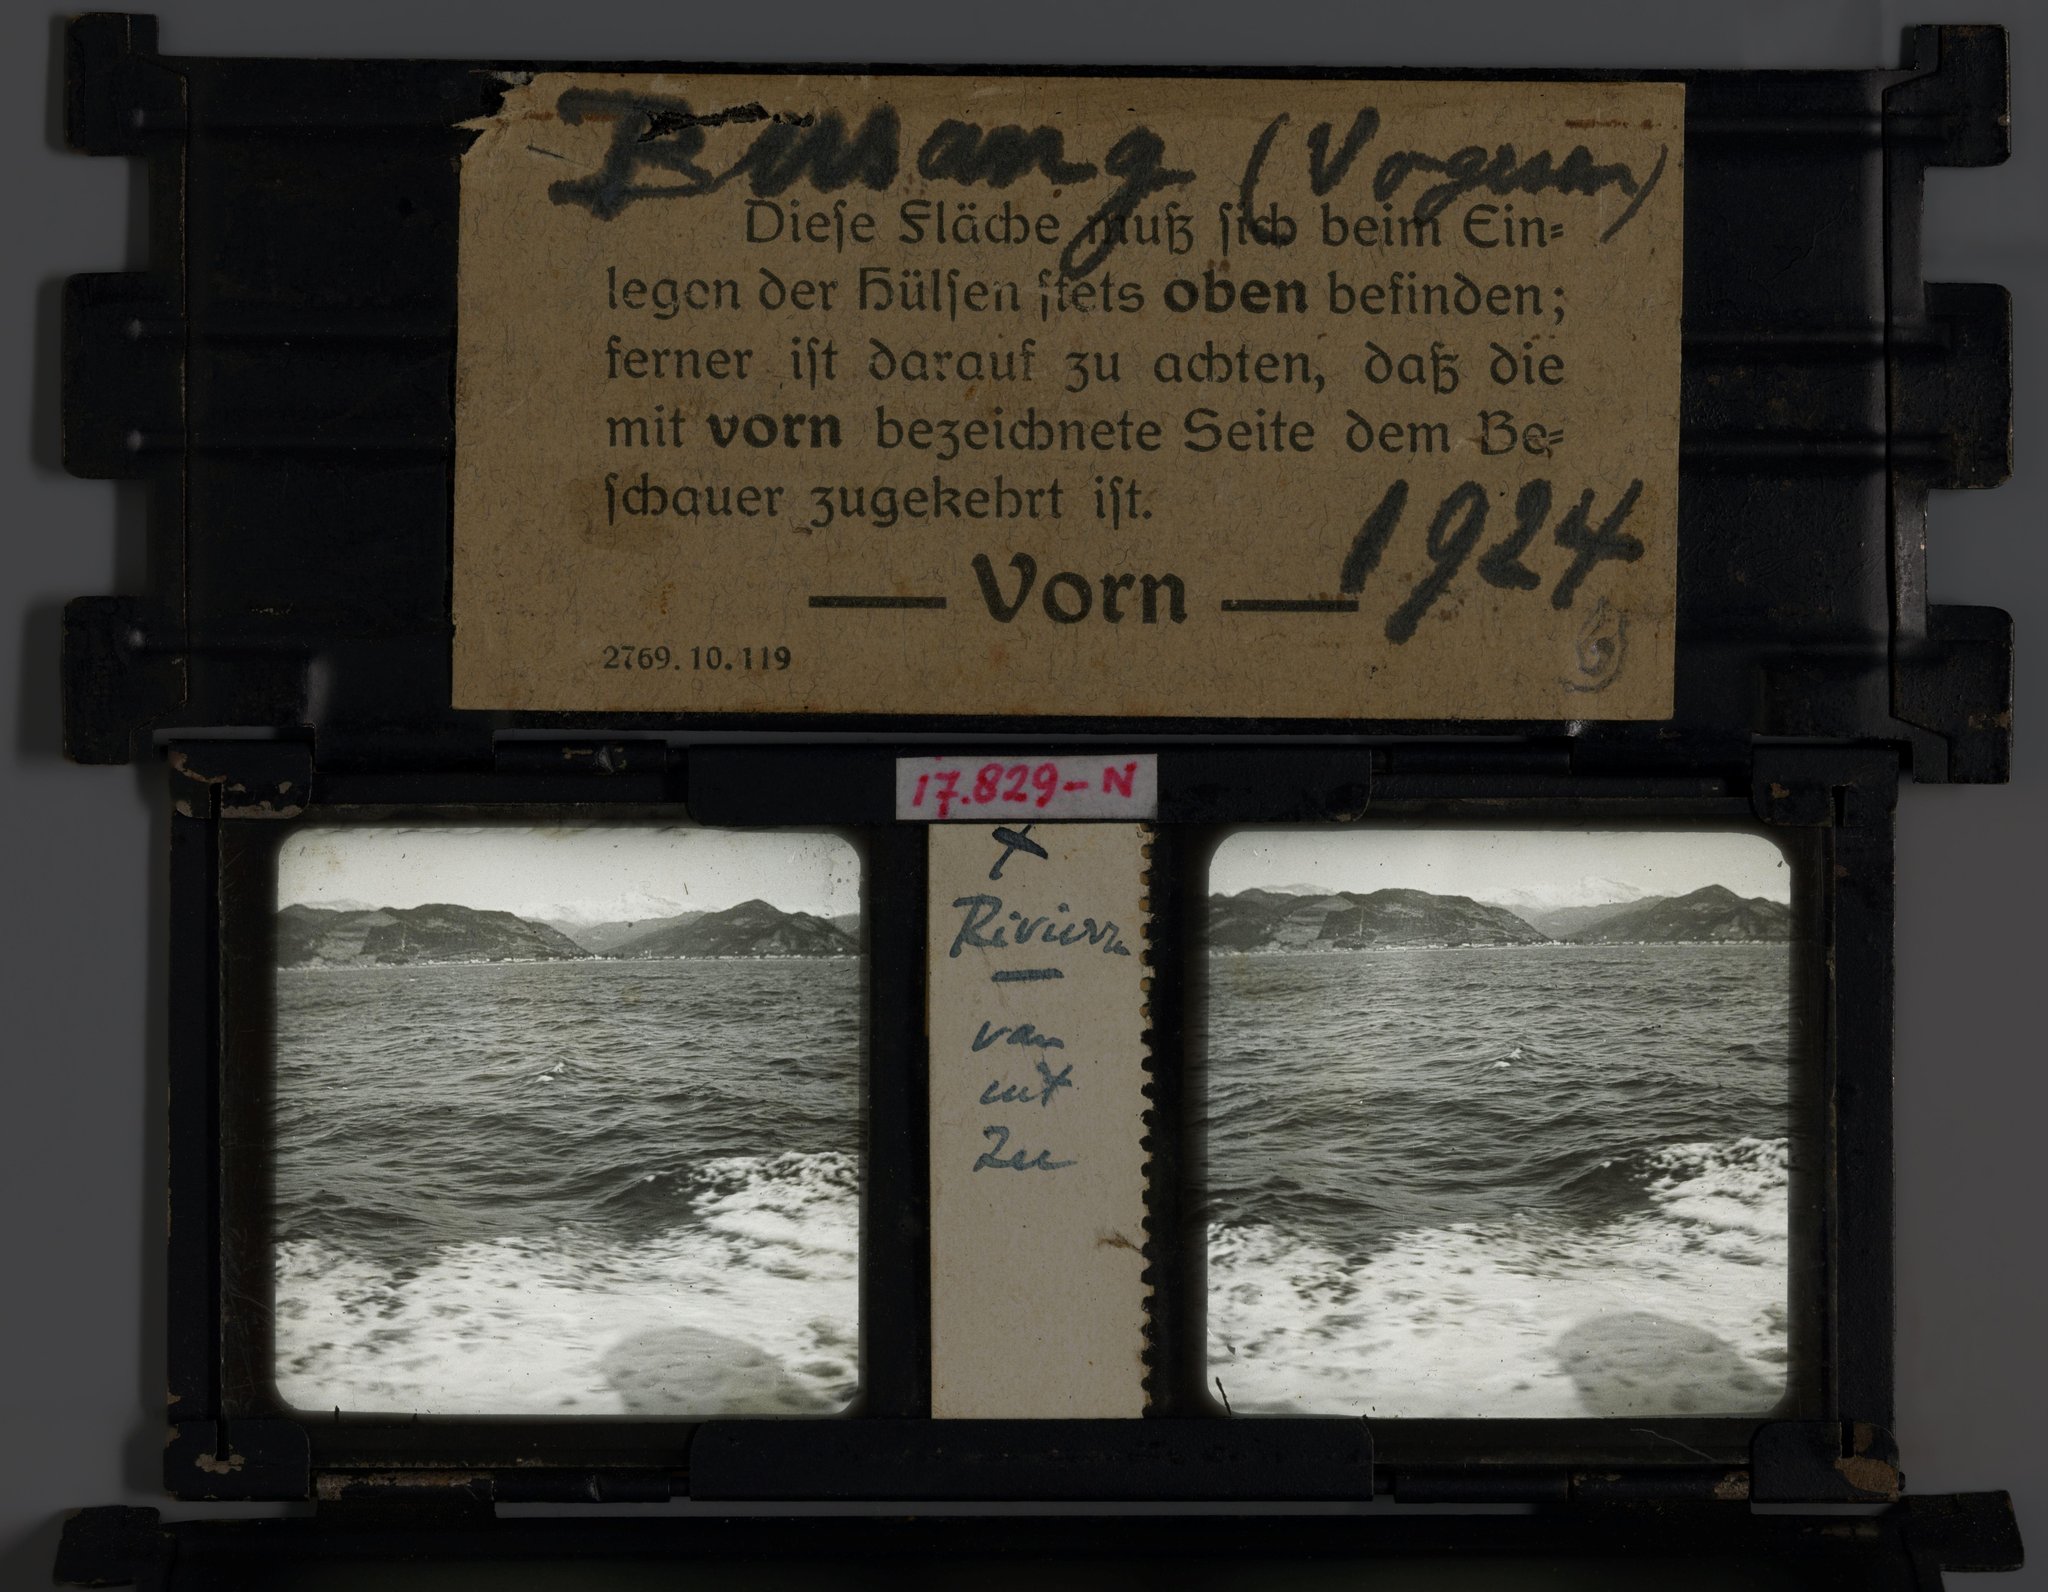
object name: stereoscopic photograph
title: Gezicht op de Rivièra vanaf zee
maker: Anonymous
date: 1924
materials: glass, metal, paper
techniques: slide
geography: mediterranean sea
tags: coast